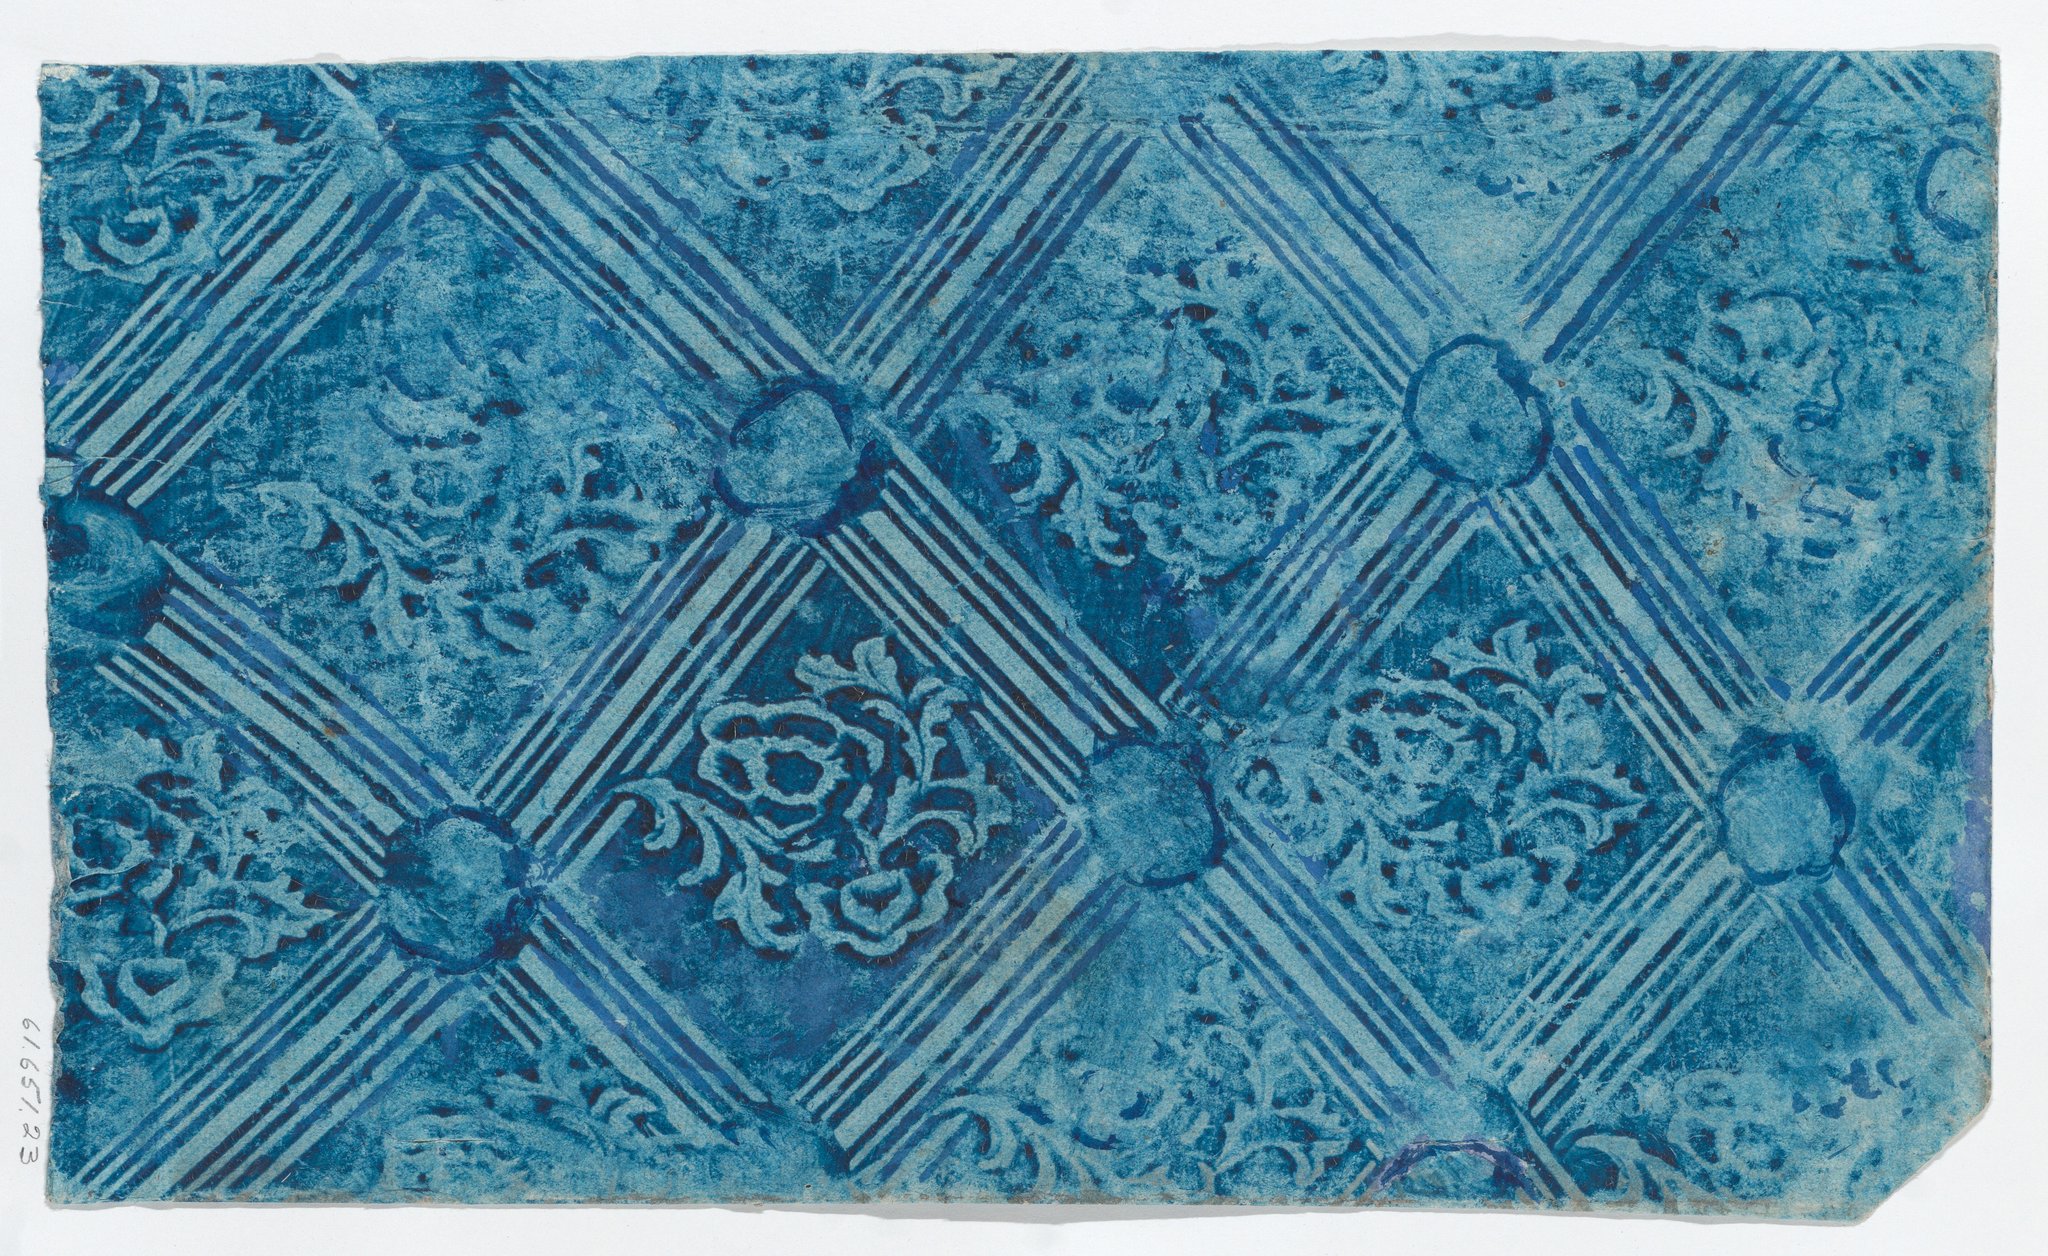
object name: print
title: Paste paper with blue stripe and floral pattern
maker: Anonymous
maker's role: artist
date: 1701-1800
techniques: relief print